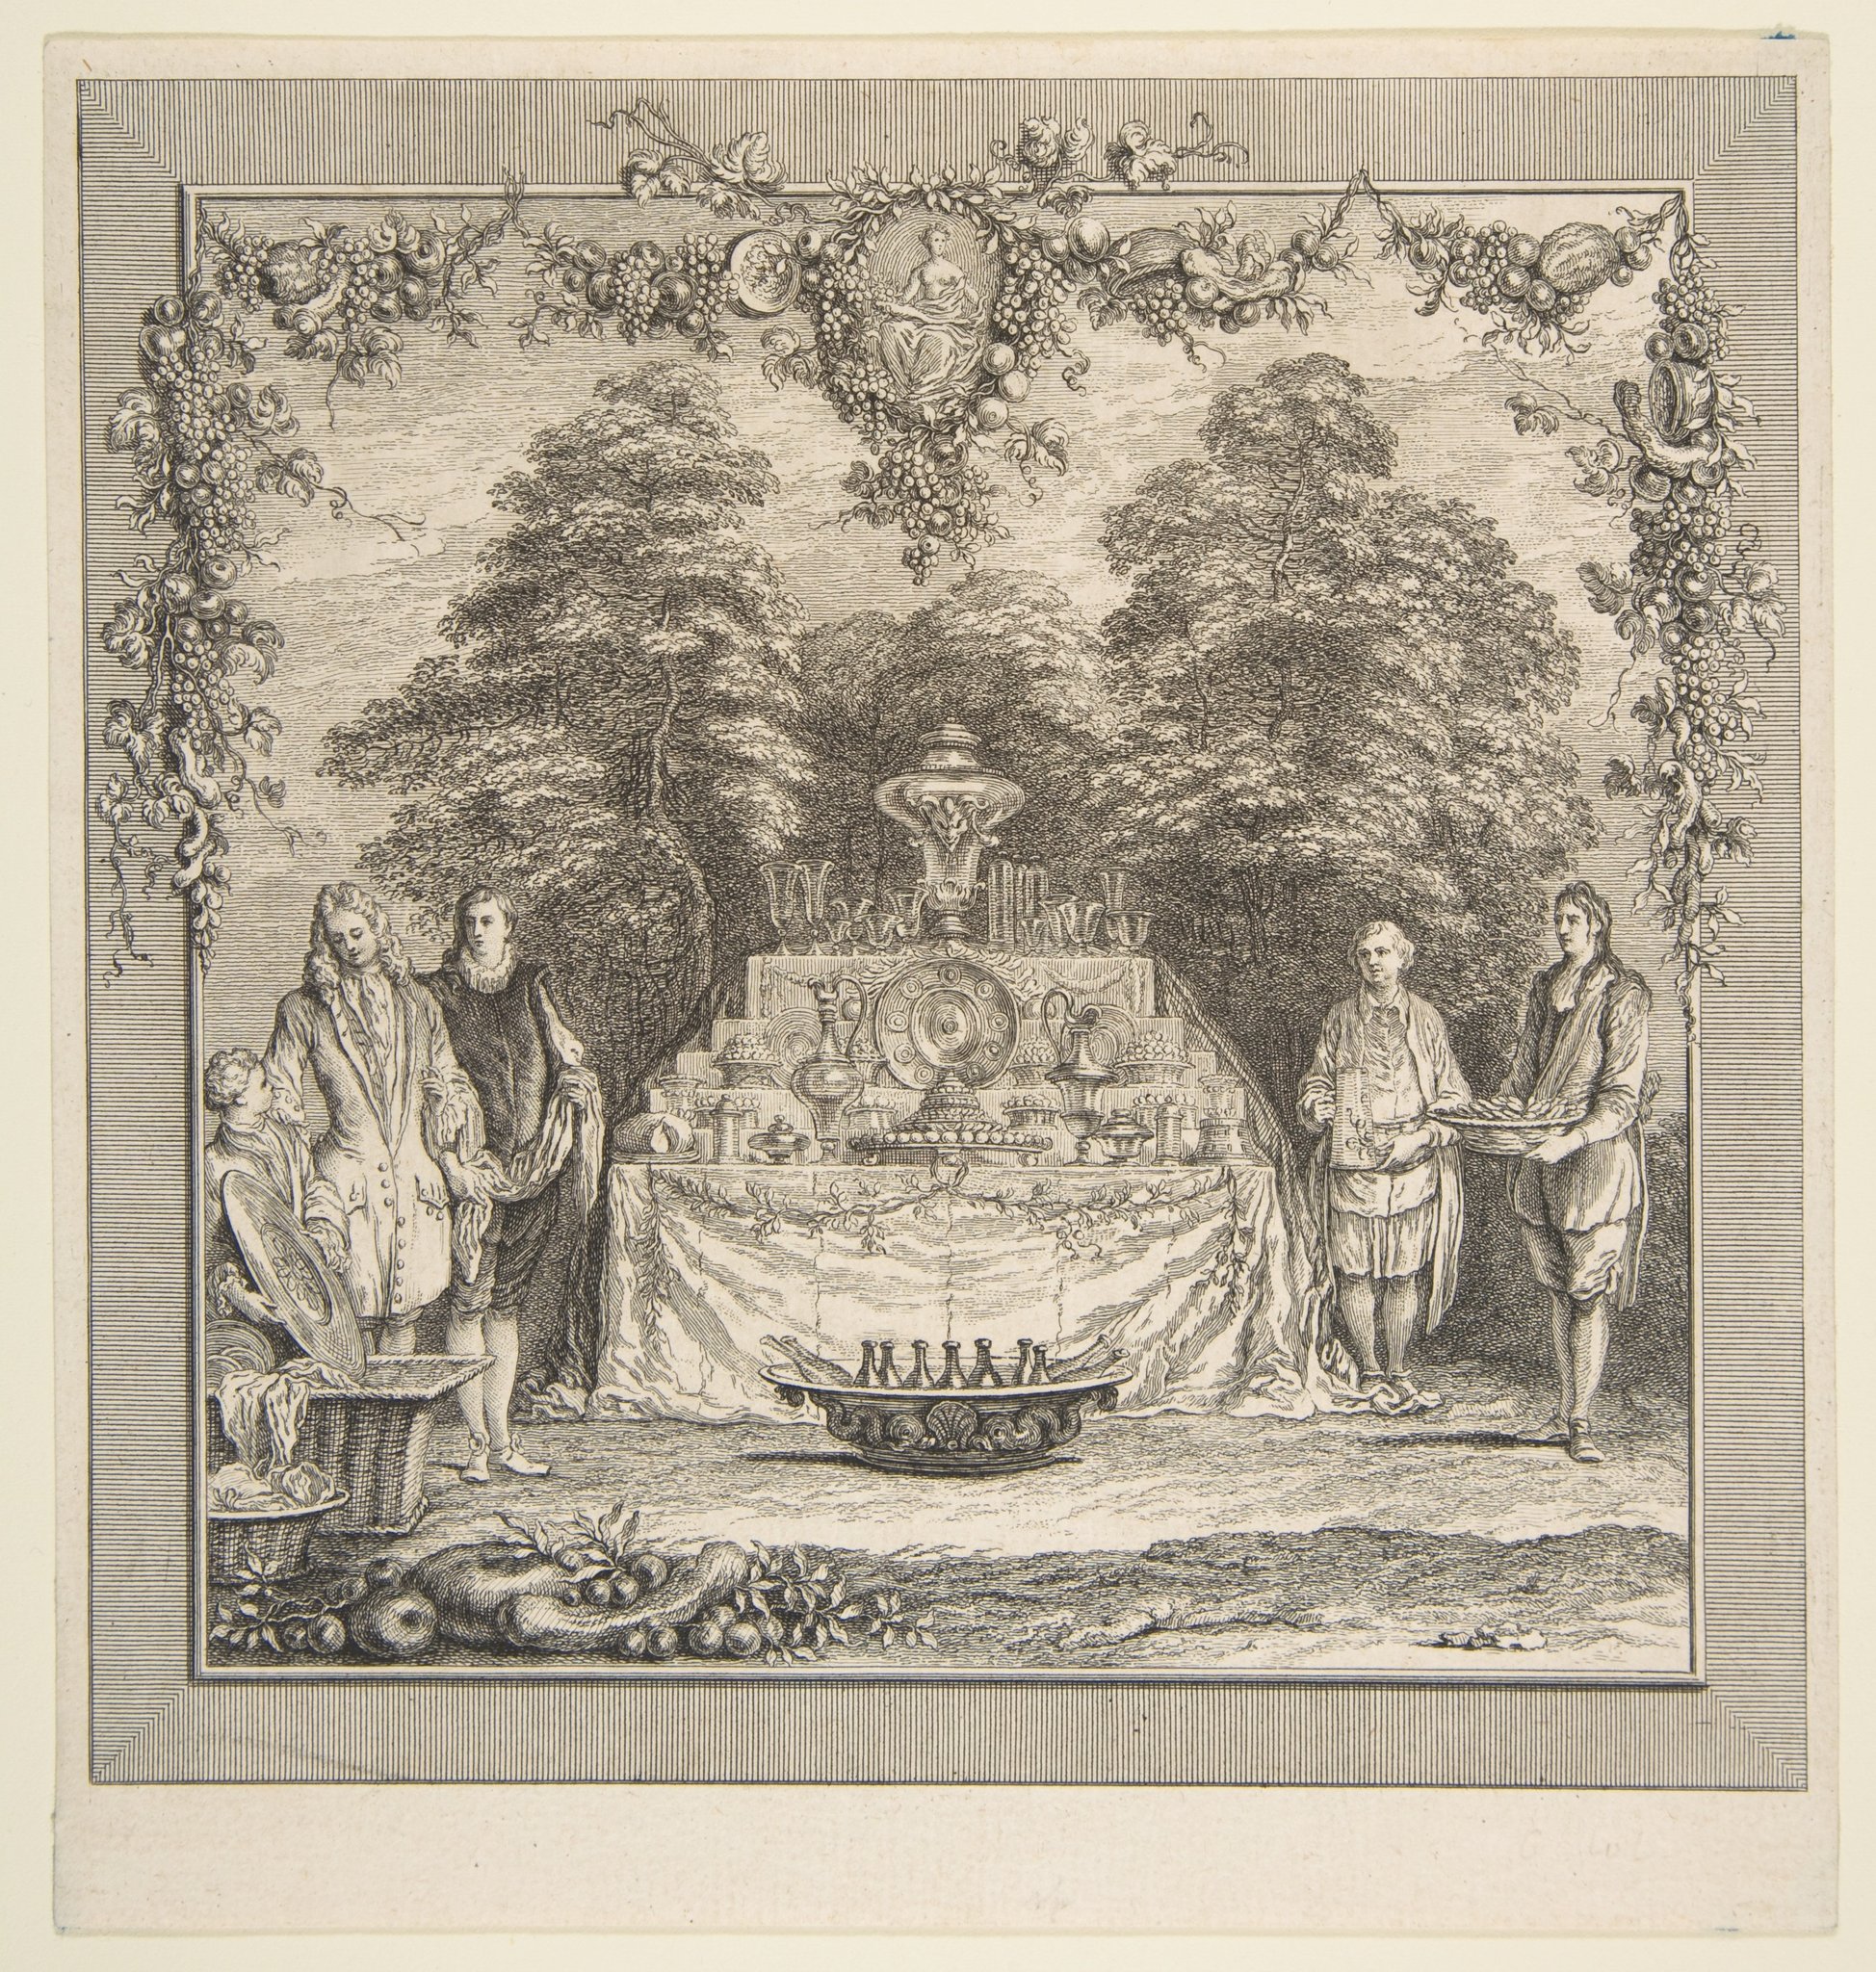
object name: print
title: La Colation preparee dans un jardin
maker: claude gillot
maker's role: artist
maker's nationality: french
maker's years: 1673-1722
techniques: etching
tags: food,gardens,men